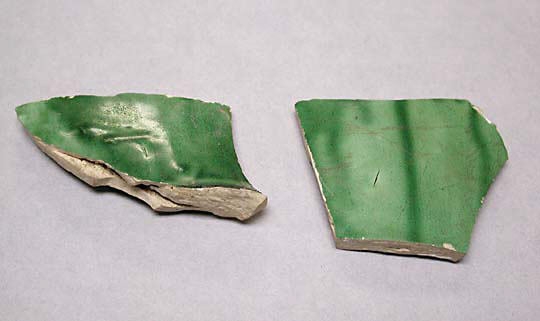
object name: ceramic fragment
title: Ceramic Fragments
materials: earthenware, glaze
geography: iraq